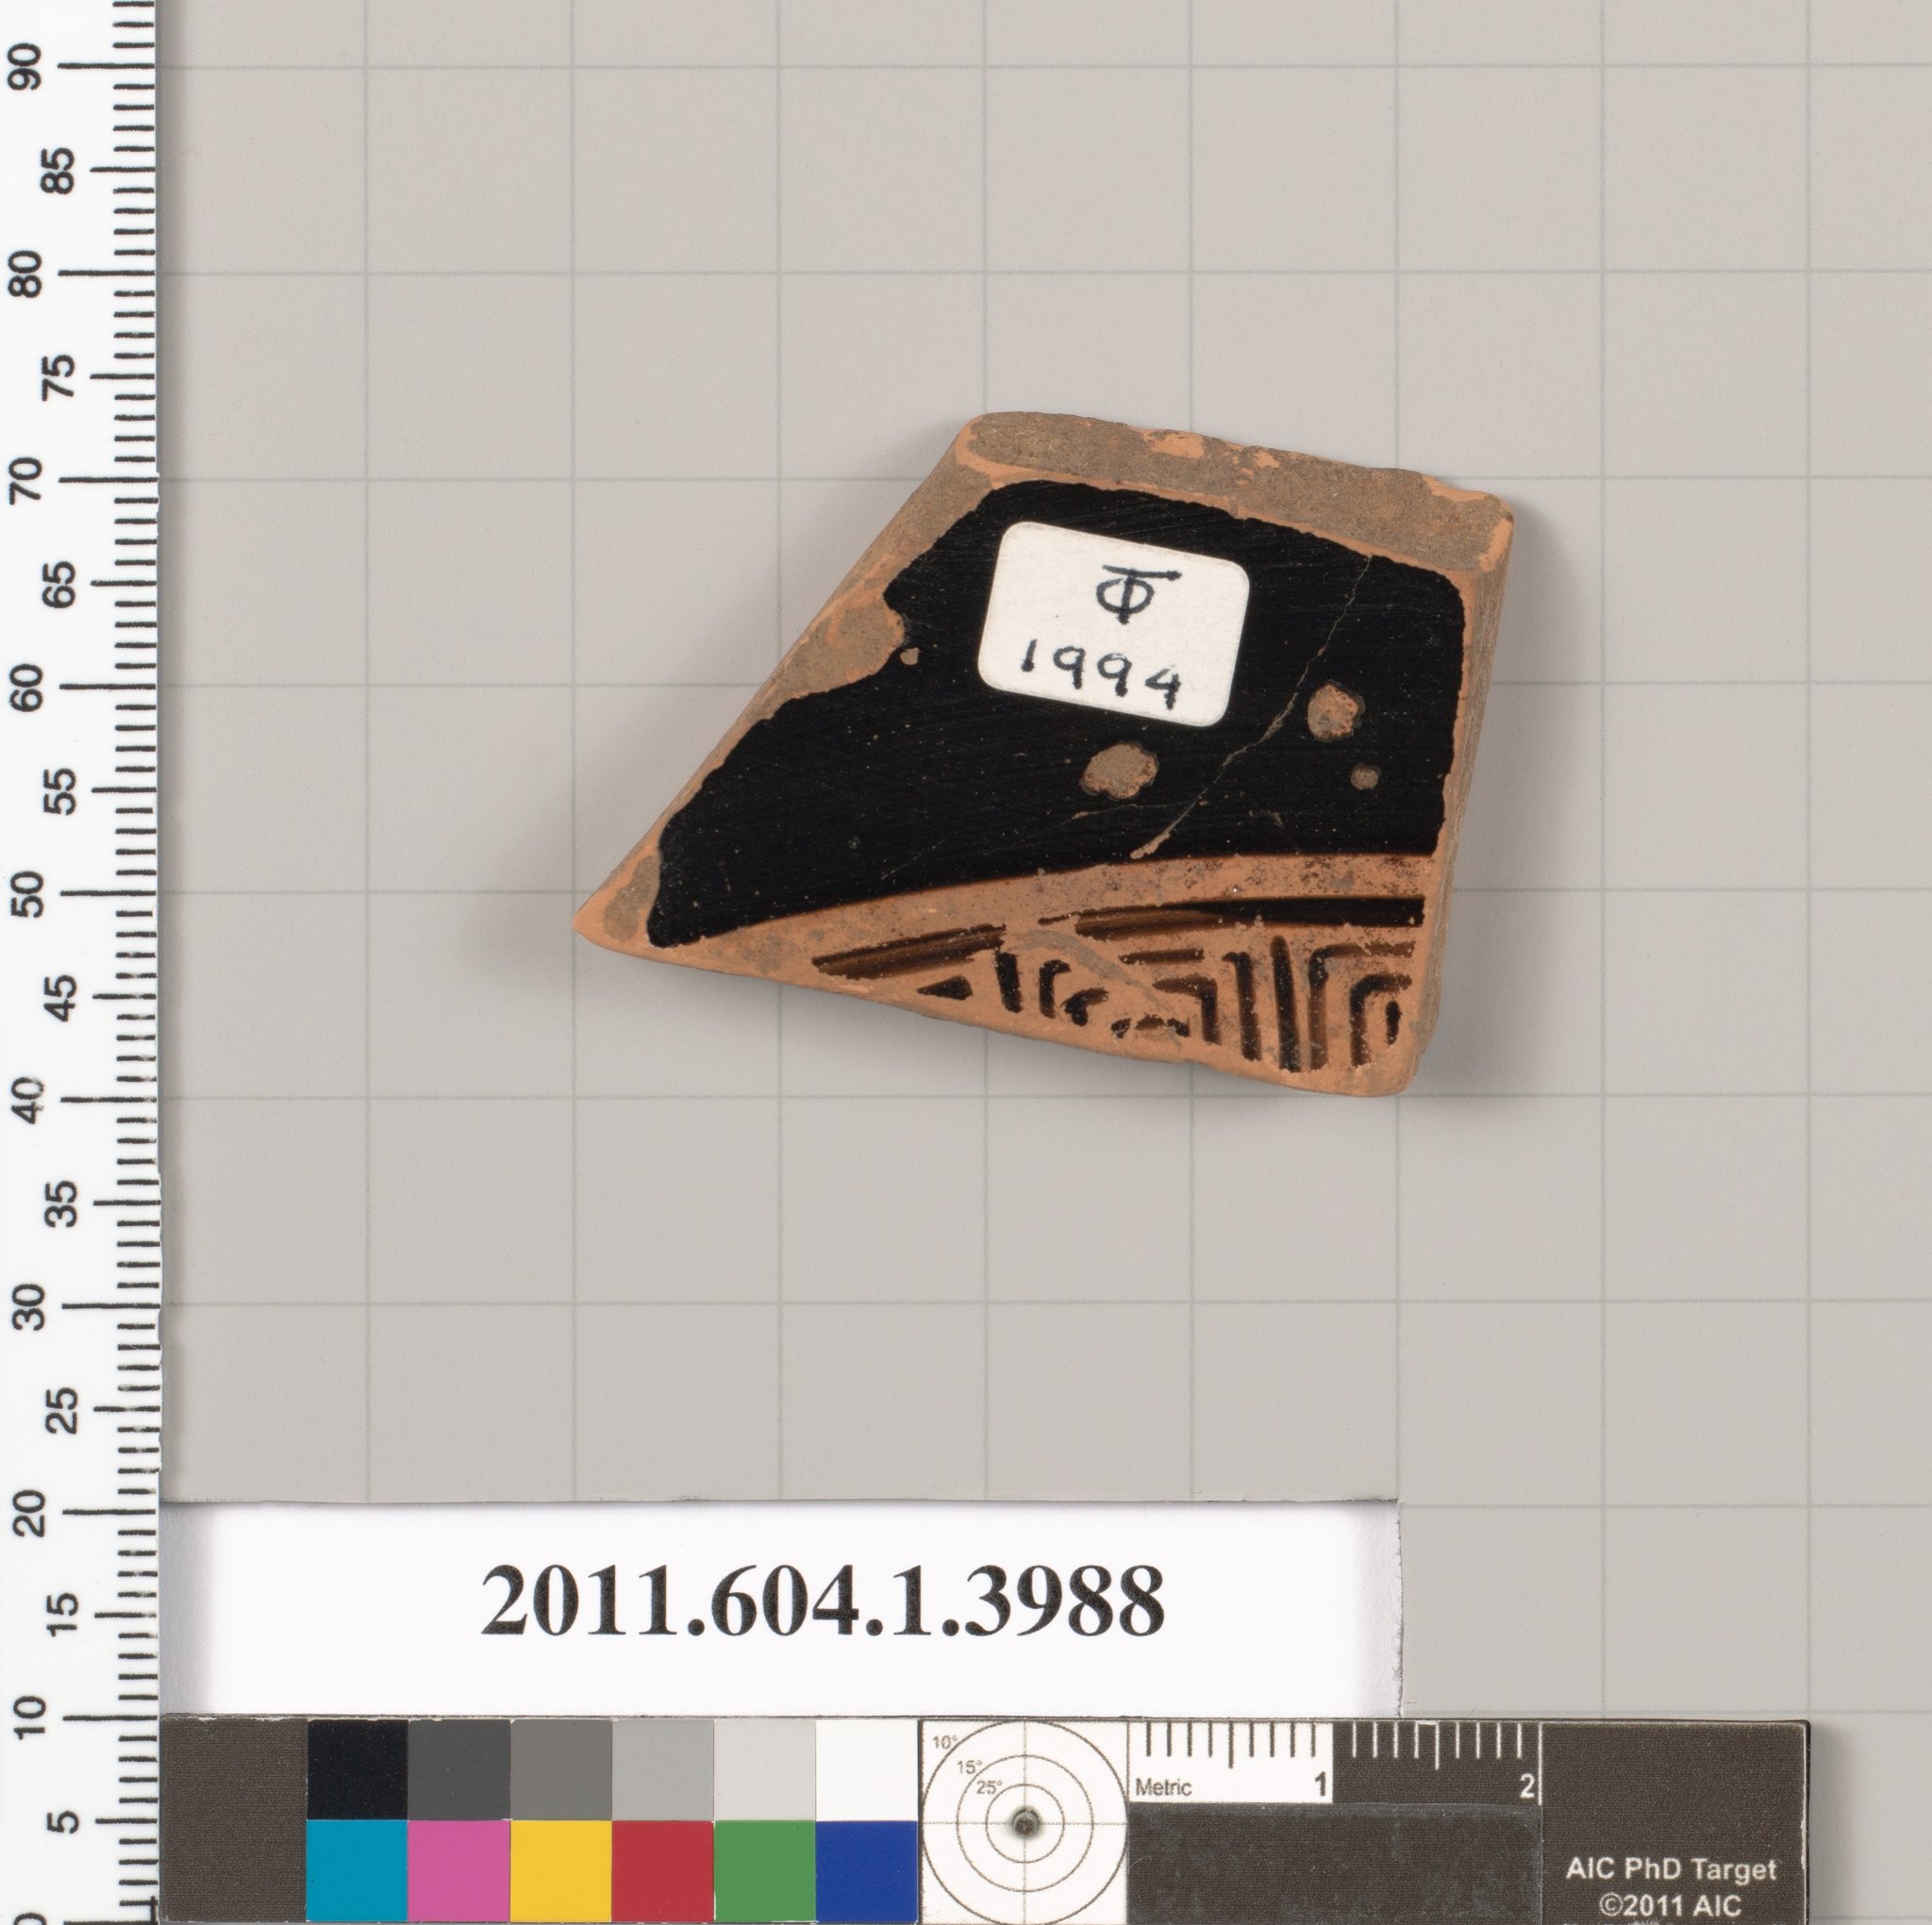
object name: kylix fragment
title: Terracotta fragment of a kylix (drinking cup)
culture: greek, attic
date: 475-451 BCE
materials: terracotta